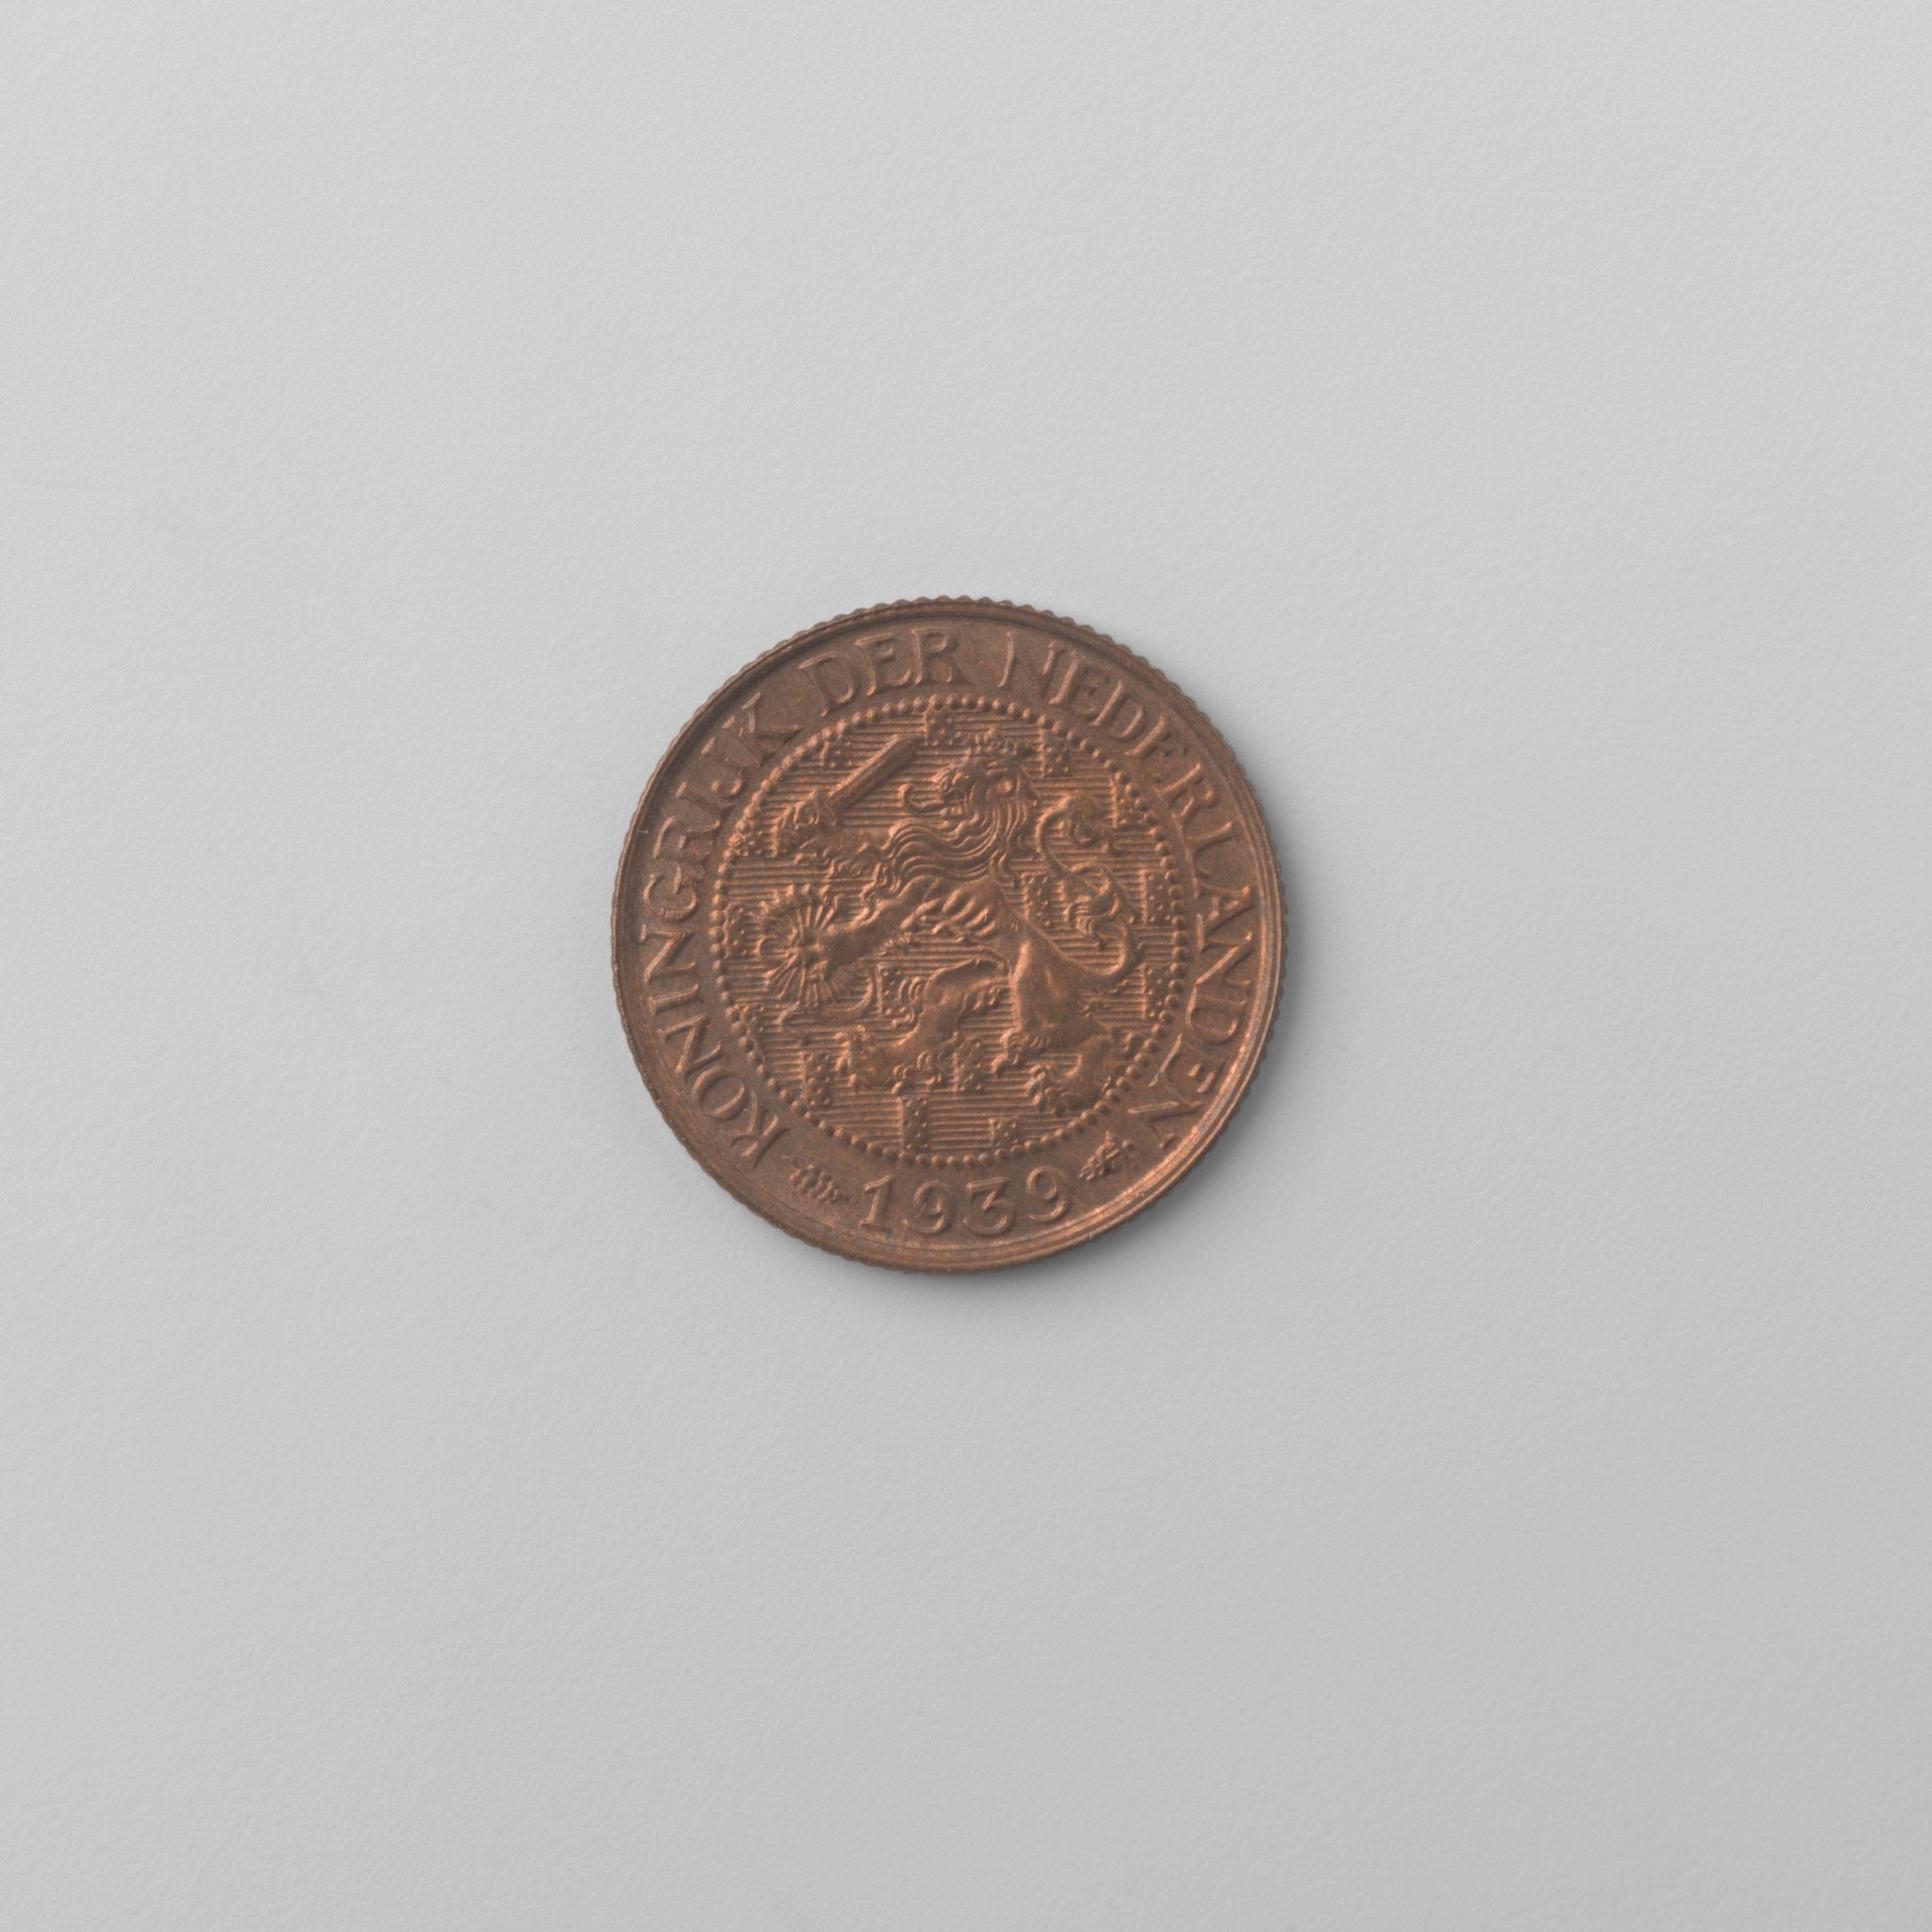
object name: coin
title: Nederland, cent,1939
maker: wilhelmina of the netherlands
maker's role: print maker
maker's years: 1880-1962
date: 1939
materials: bronze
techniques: striking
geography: utrecht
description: Bronzen munt. Voorzijde: in een veld rijkswapen. Jaartal onderaan in omschrift. Keerzijde: binnen twee samengebonden oranjetakken waarde-aanduiding 1 cent. Kartelrand.